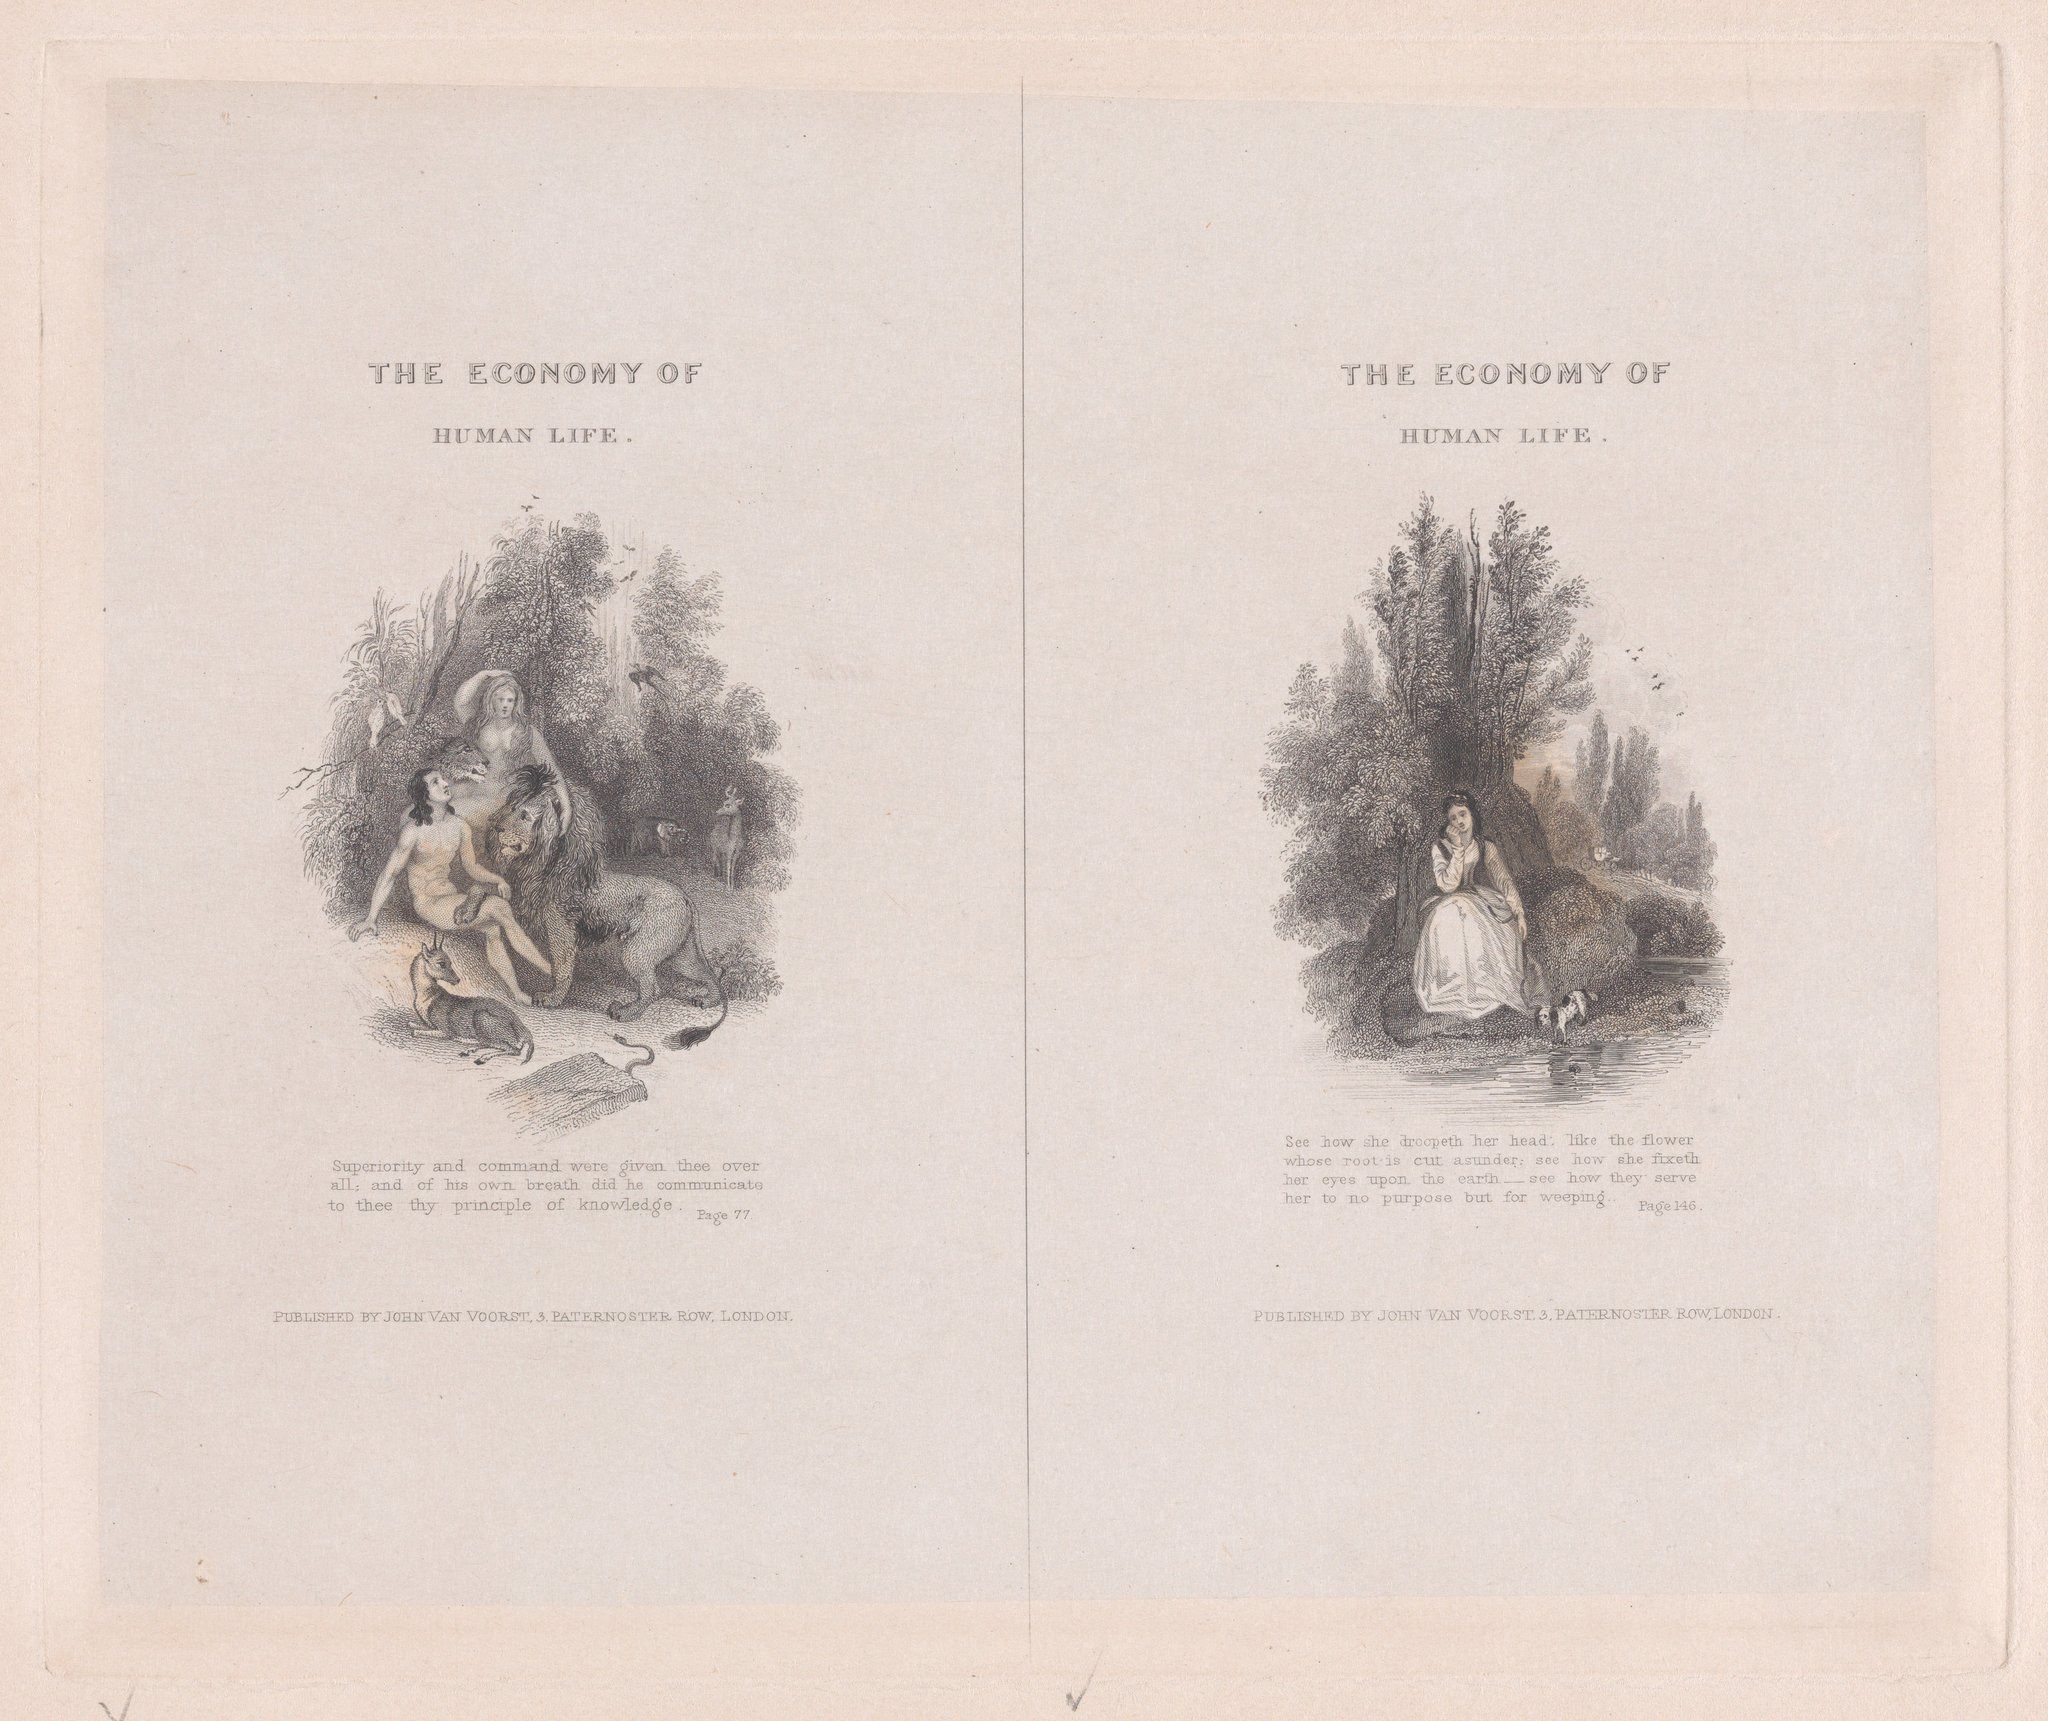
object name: print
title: Two illustrations for "The Economy of Human Life"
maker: frank howard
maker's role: artist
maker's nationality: british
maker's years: 1805-1866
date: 1834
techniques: printmaking, engraving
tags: men,women,deer,dogs,lions